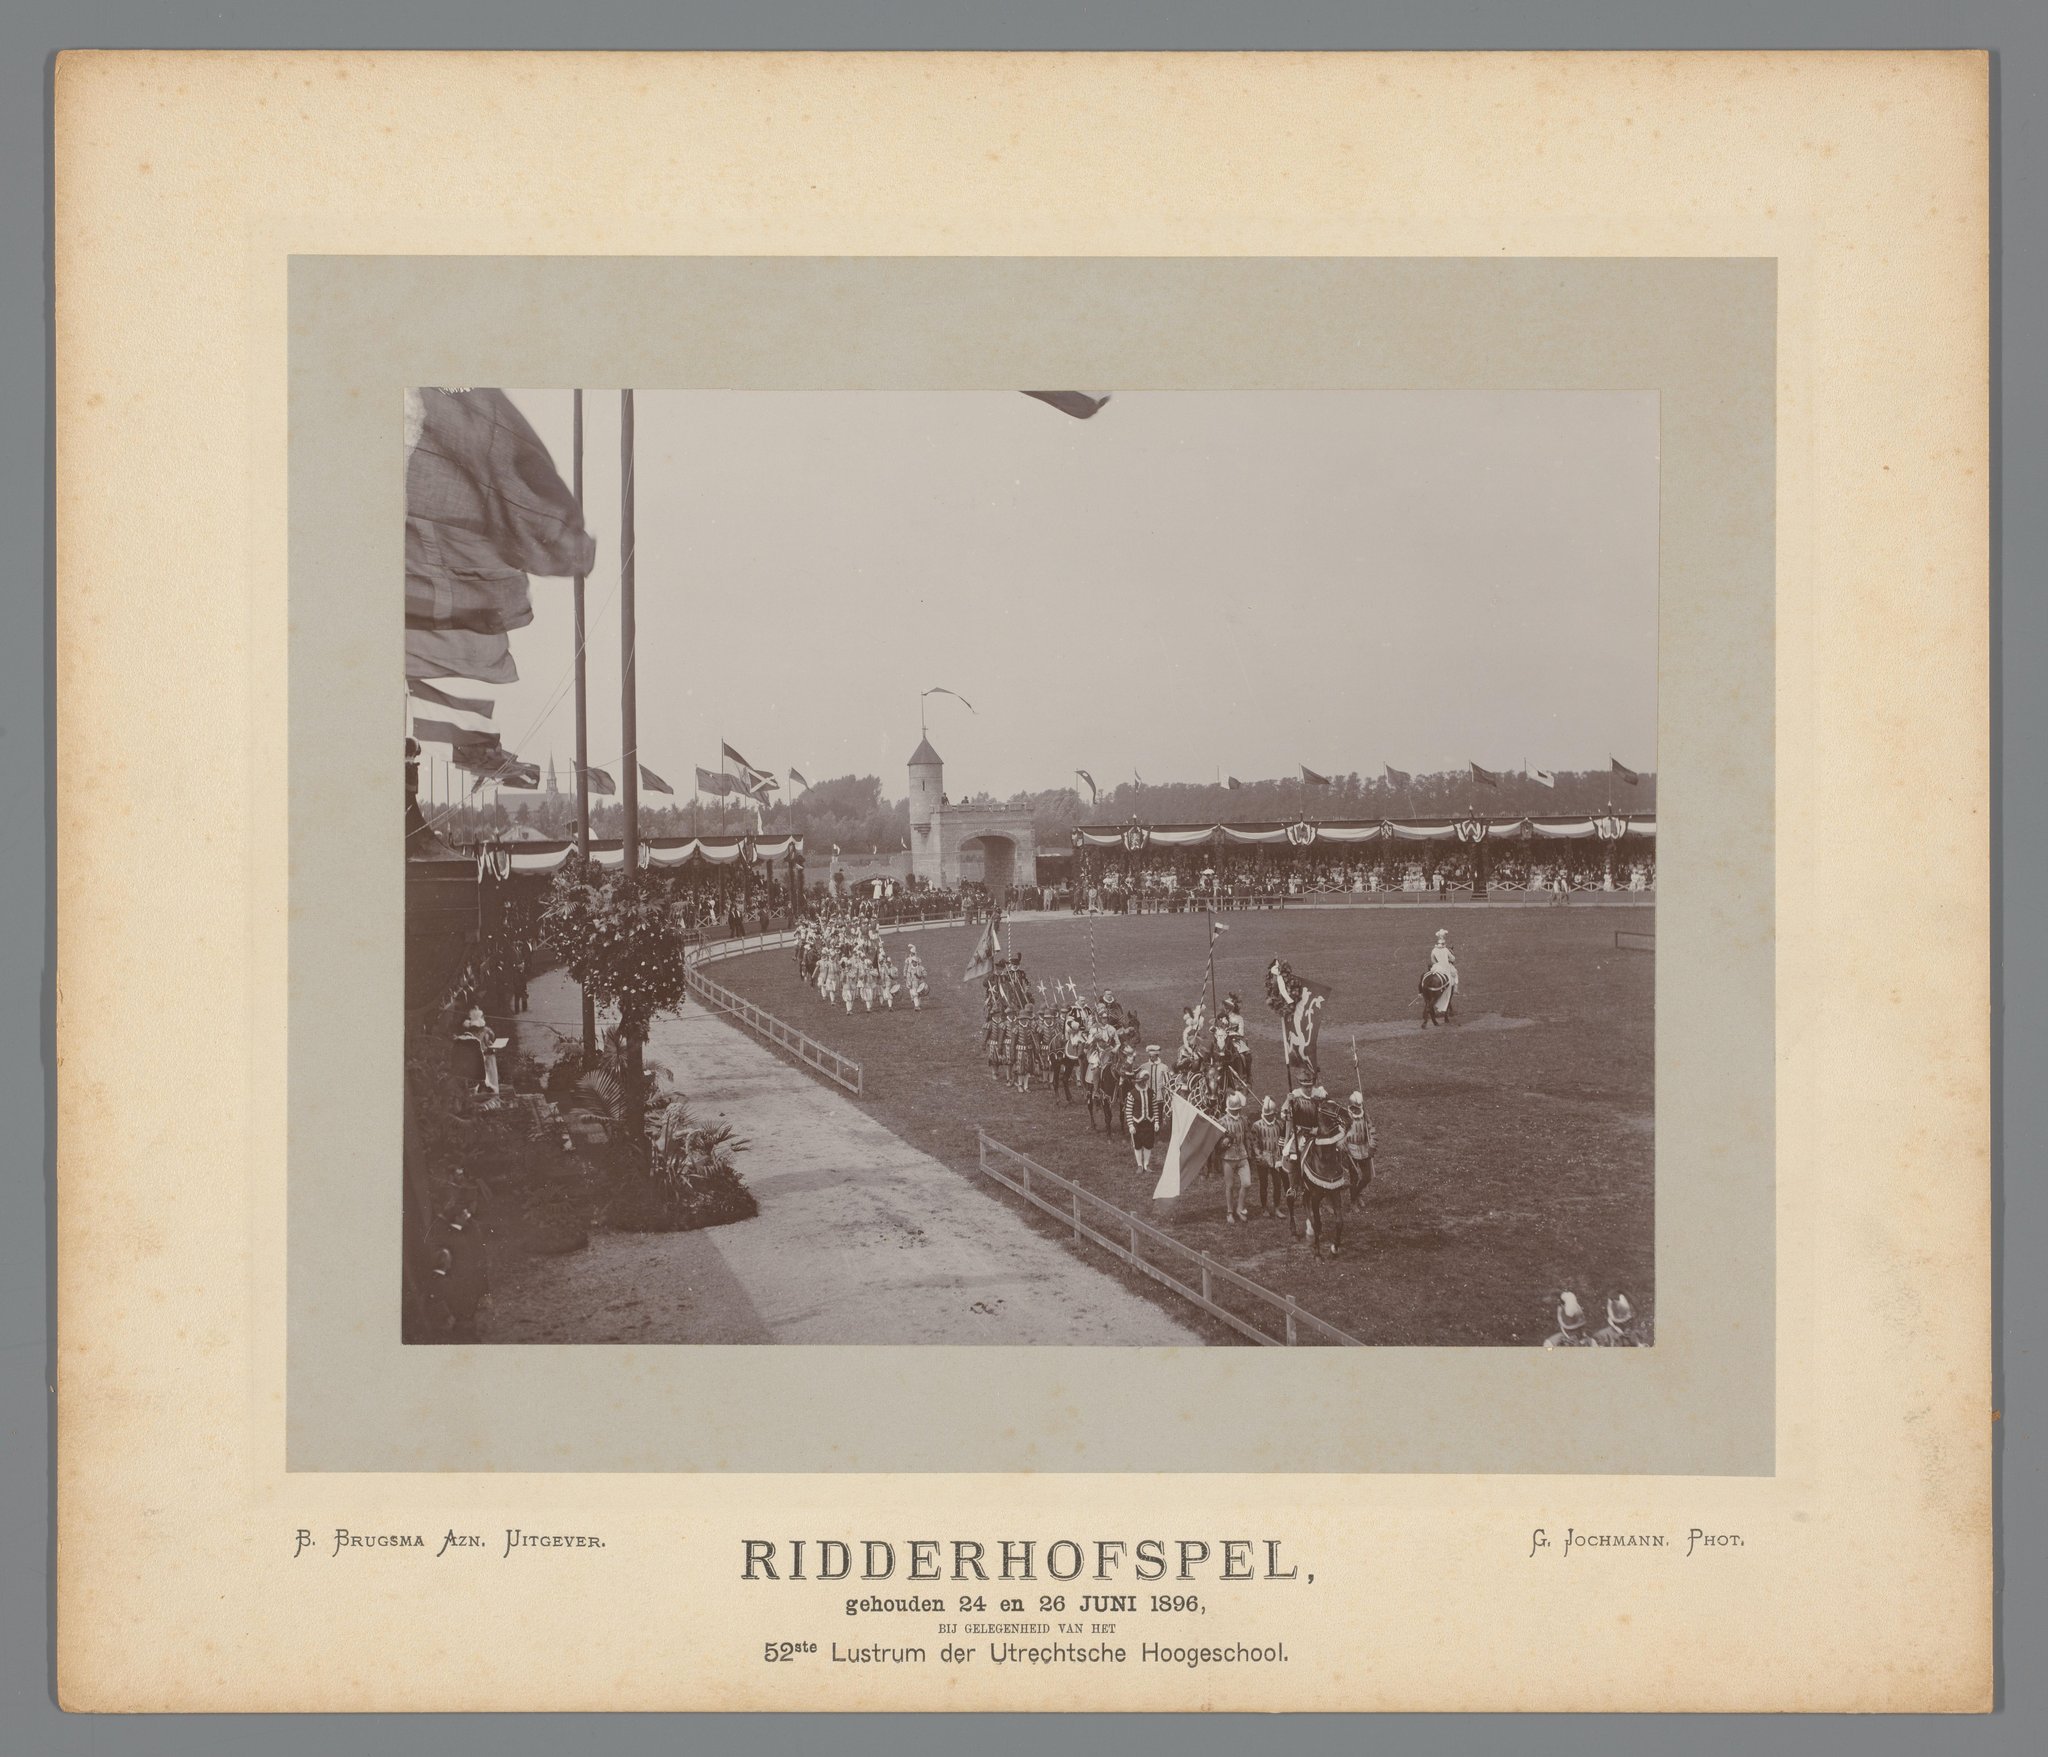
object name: photograph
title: Ridderhofspel, gehouden 24 en 26 juni 1896, bij gelegenheid van het 52ste Lustrum der Utrechtsche Hoogeschool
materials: cardboard, paper, photographic support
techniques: collodion silver print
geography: utrecht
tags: public festivities (+ parade, pageant, cavalcade ~ festive activities), (medieval) fighting contest, utrecht